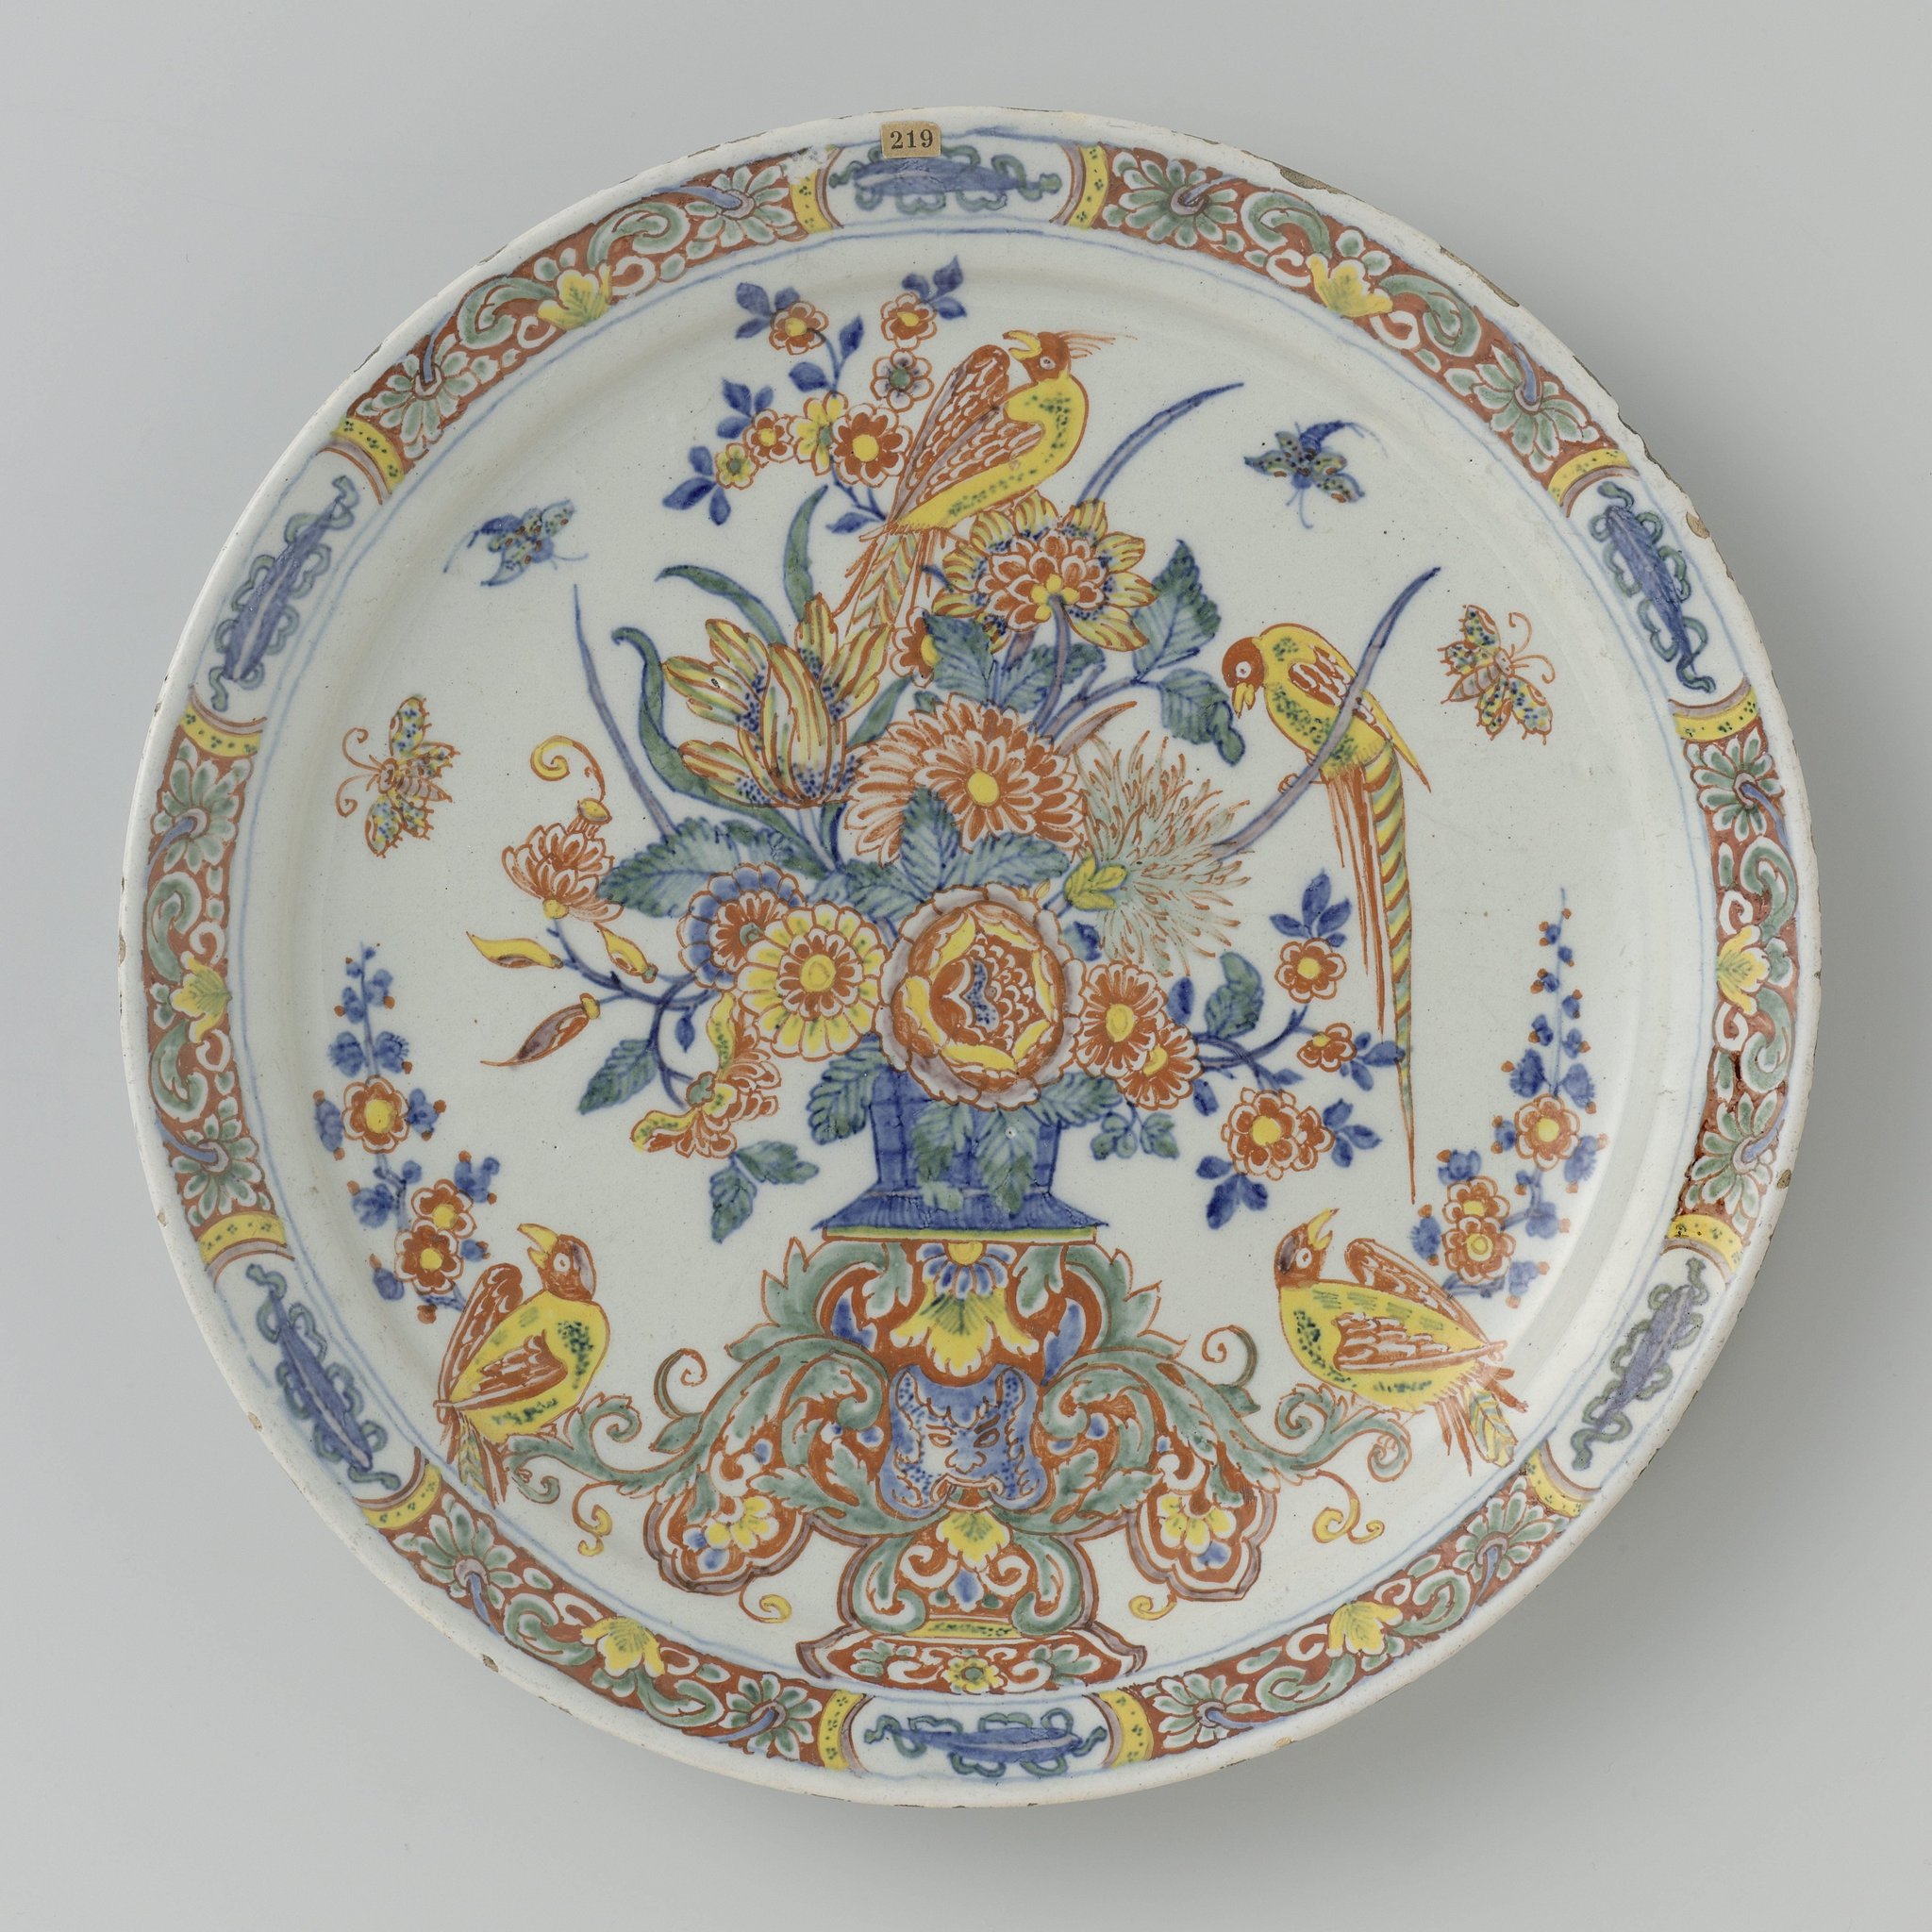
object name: plate dish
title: Bord, veelkleurig beschilderd met een korf met bloemen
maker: Anonymous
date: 1710-1730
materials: faience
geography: delft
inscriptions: seal: ‘219’, collector's mark: ‘collection J.F. Loudon’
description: Bord van faïence. Veelkleurig beschilderd met een korf met bloemen. Rank met ranken en Chinese motieven.